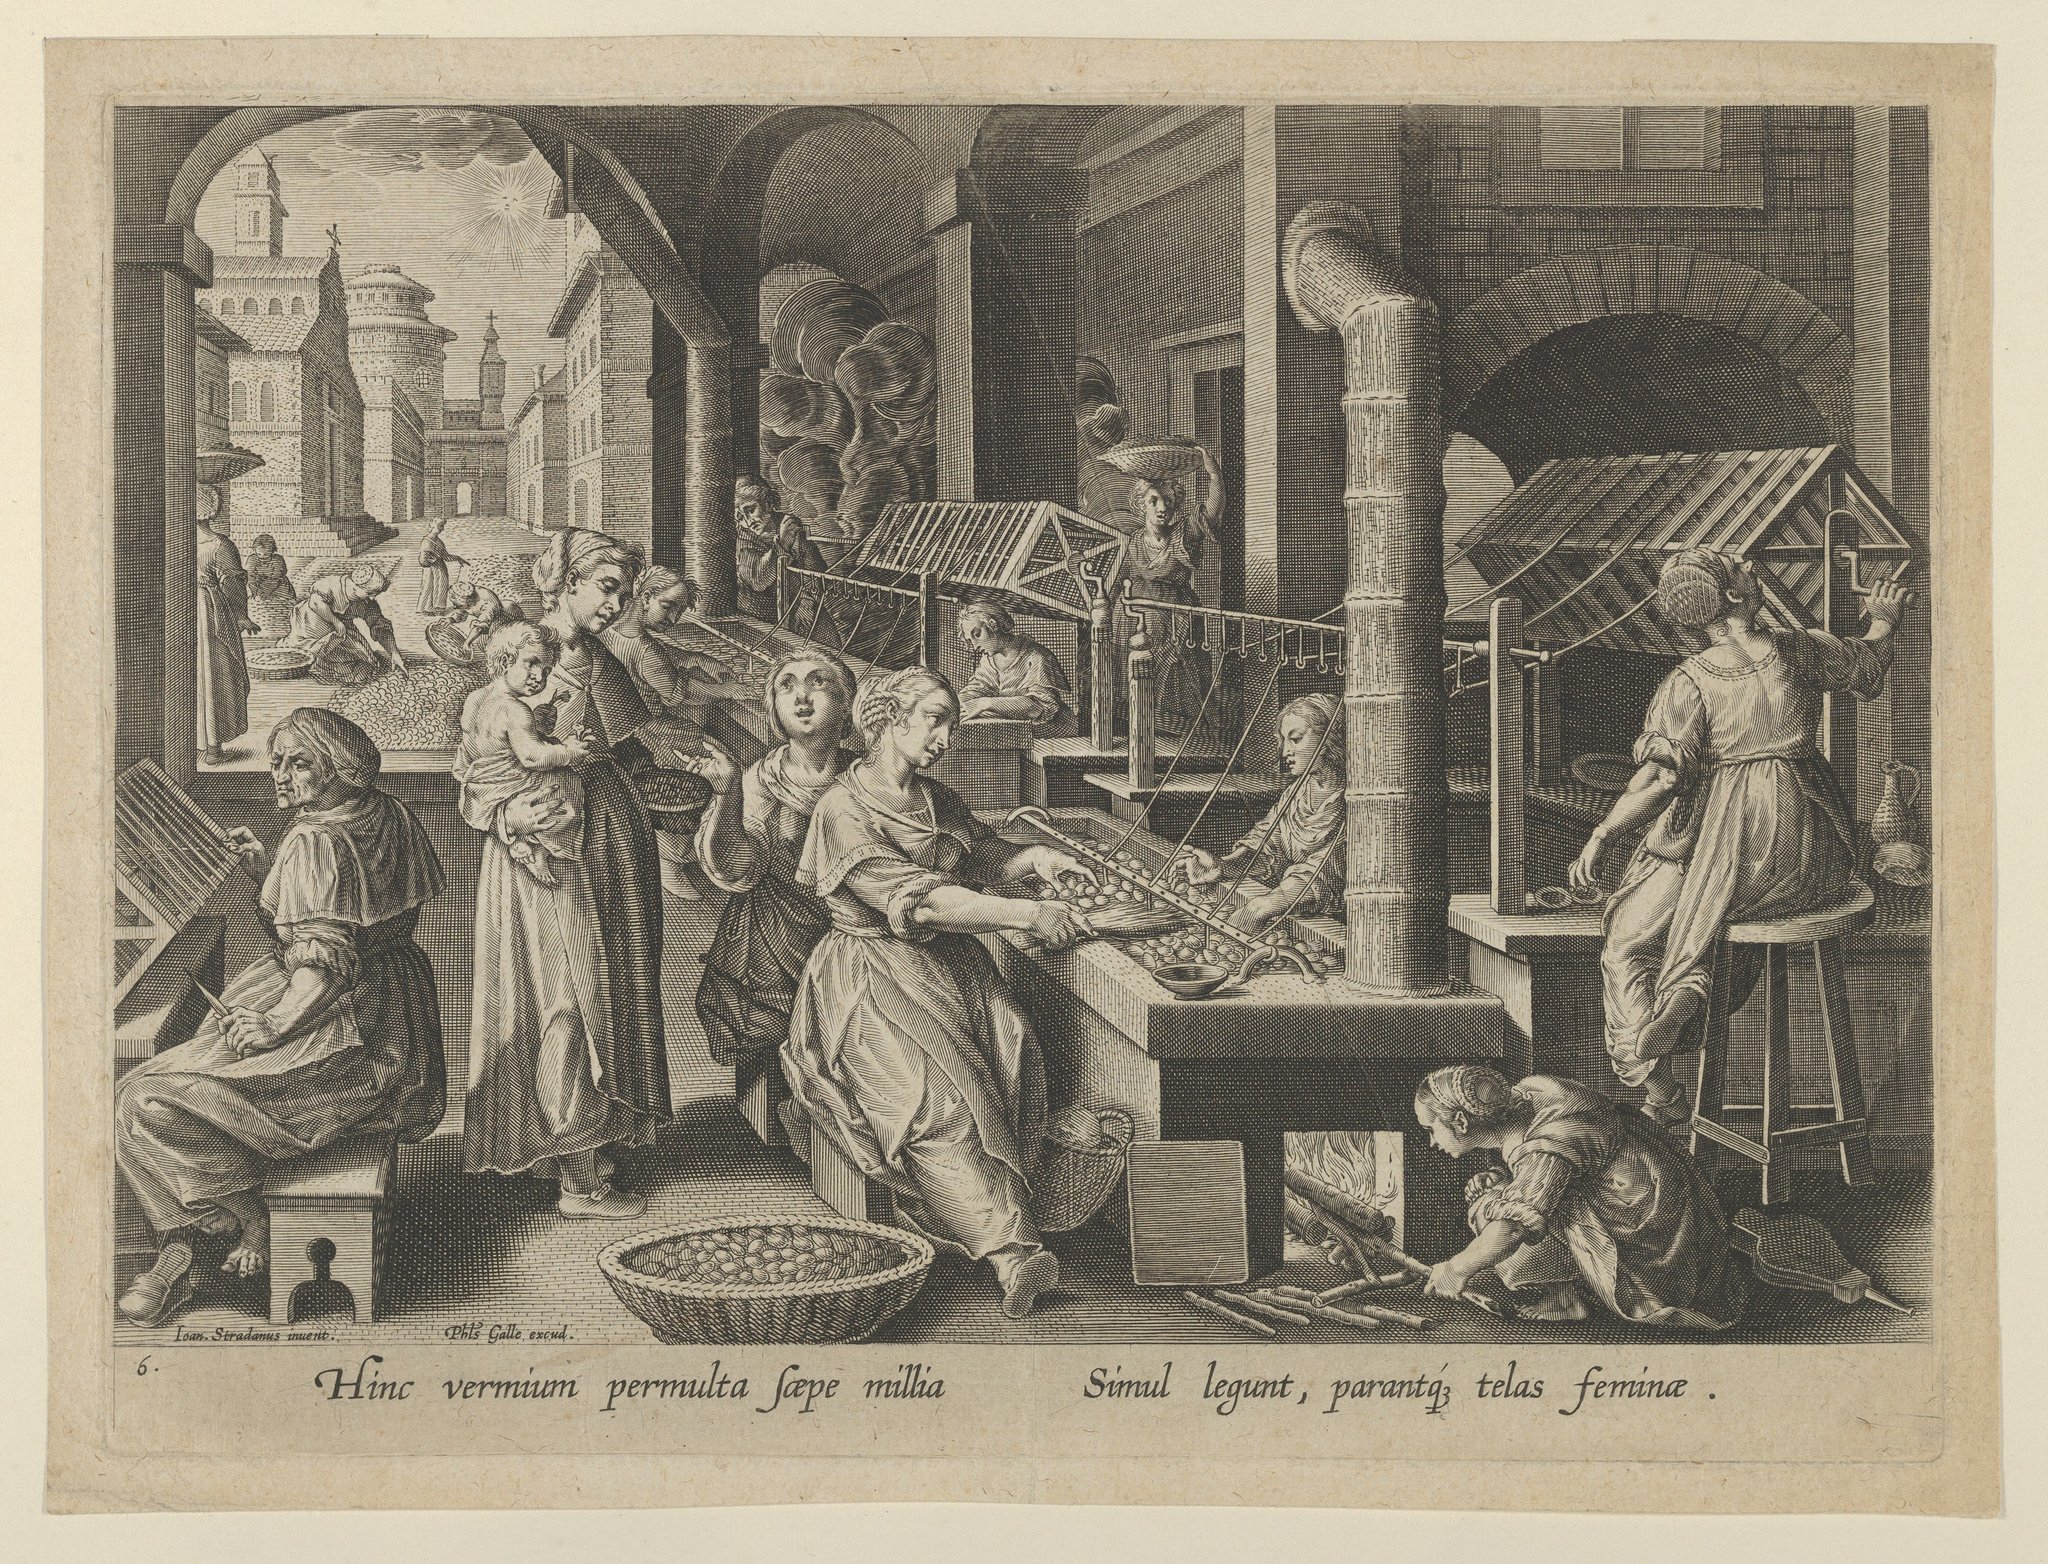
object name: print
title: The Reeling of Silk, Plate 6 from "The Introduction of the Silkworm" [Vermis Sericus]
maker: karel van mallery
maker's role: artist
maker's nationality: netherlandish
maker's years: 1571-1645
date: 1595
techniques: engraving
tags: women,working,industry